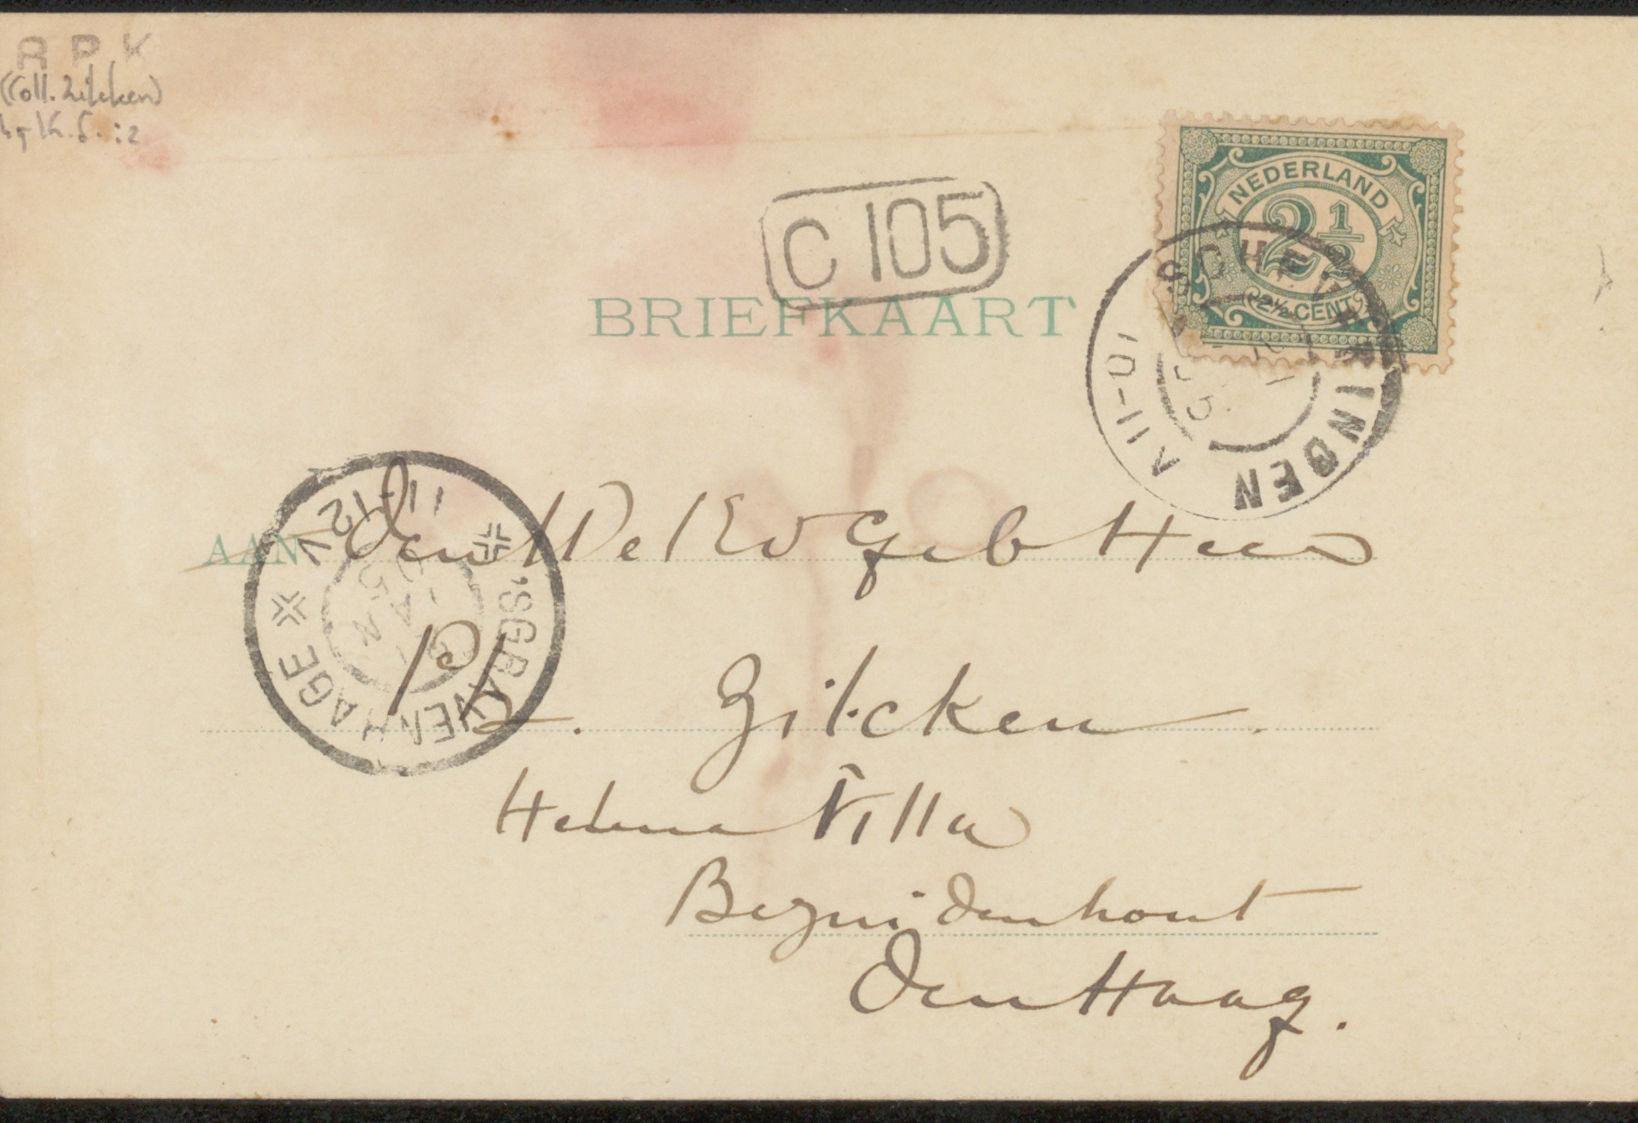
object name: postcard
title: Briefkaart aan Philip Zilcken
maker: karel sluijterman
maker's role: designer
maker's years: 1863-1931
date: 1905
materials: cardboard, ink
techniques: pen, writing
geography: scheveningen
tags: the hague, painter, draughtsman, philip zilcken, deventer, arnhem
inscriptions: collector's mark: ‘RPK’